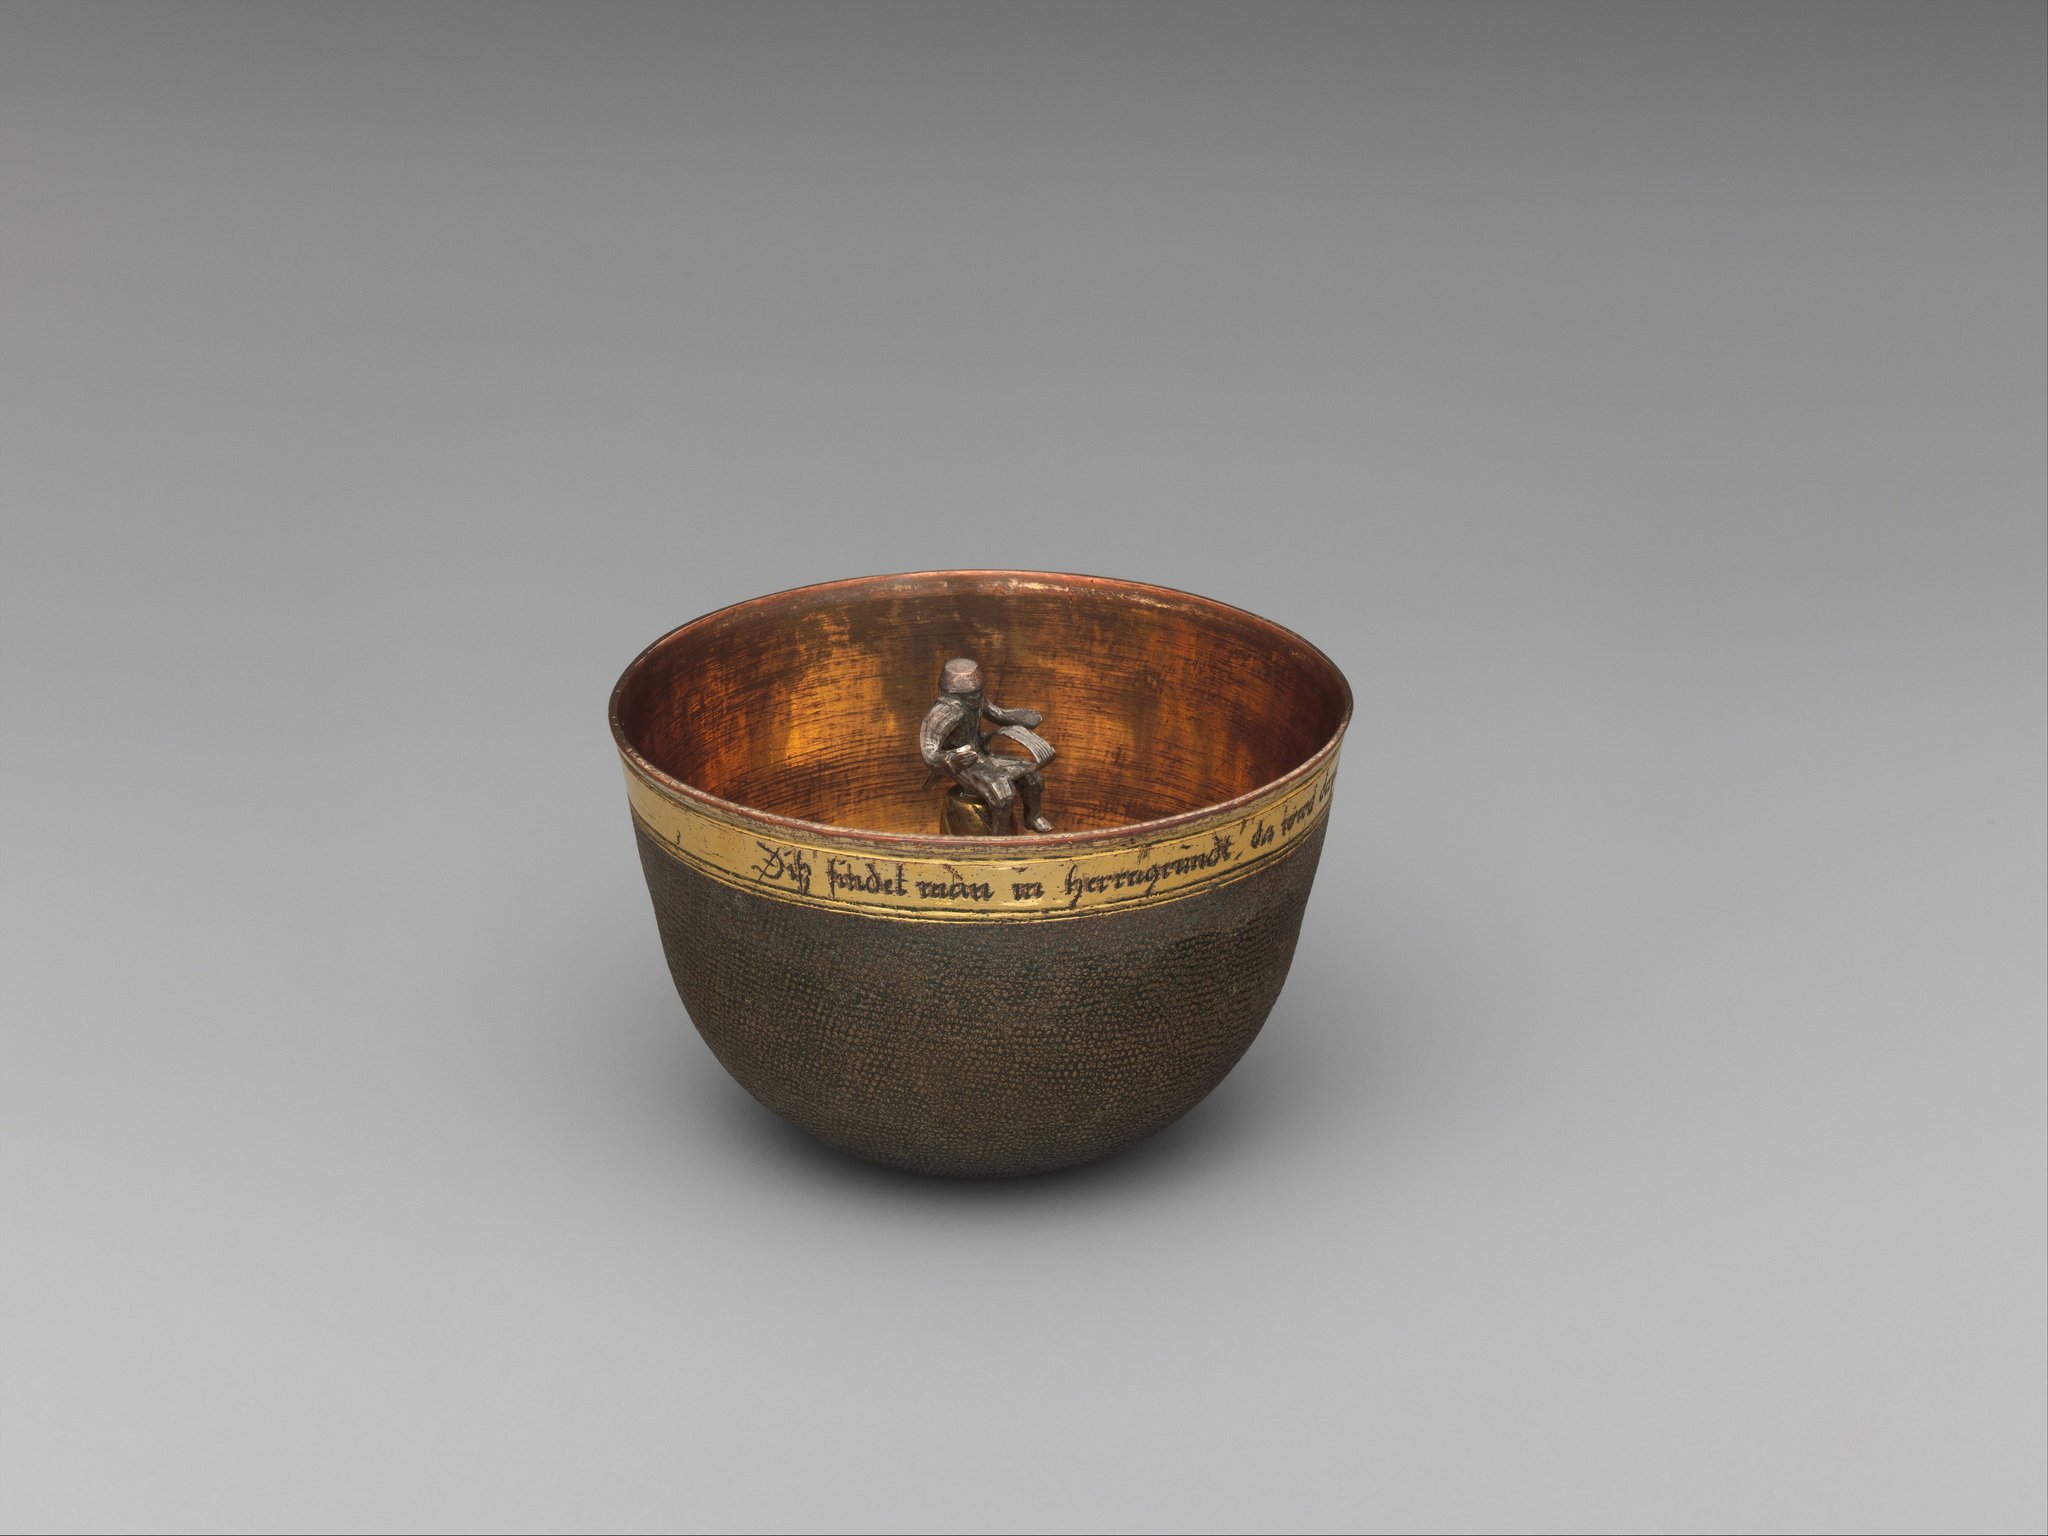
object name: beaker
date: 1701-1733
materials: alloy, copper, silver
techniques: gilding